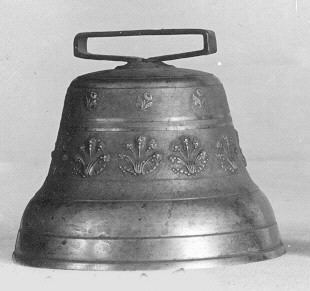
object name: ngonge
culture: congolese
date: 1867-1900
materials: metal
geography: democratic republic of the congo